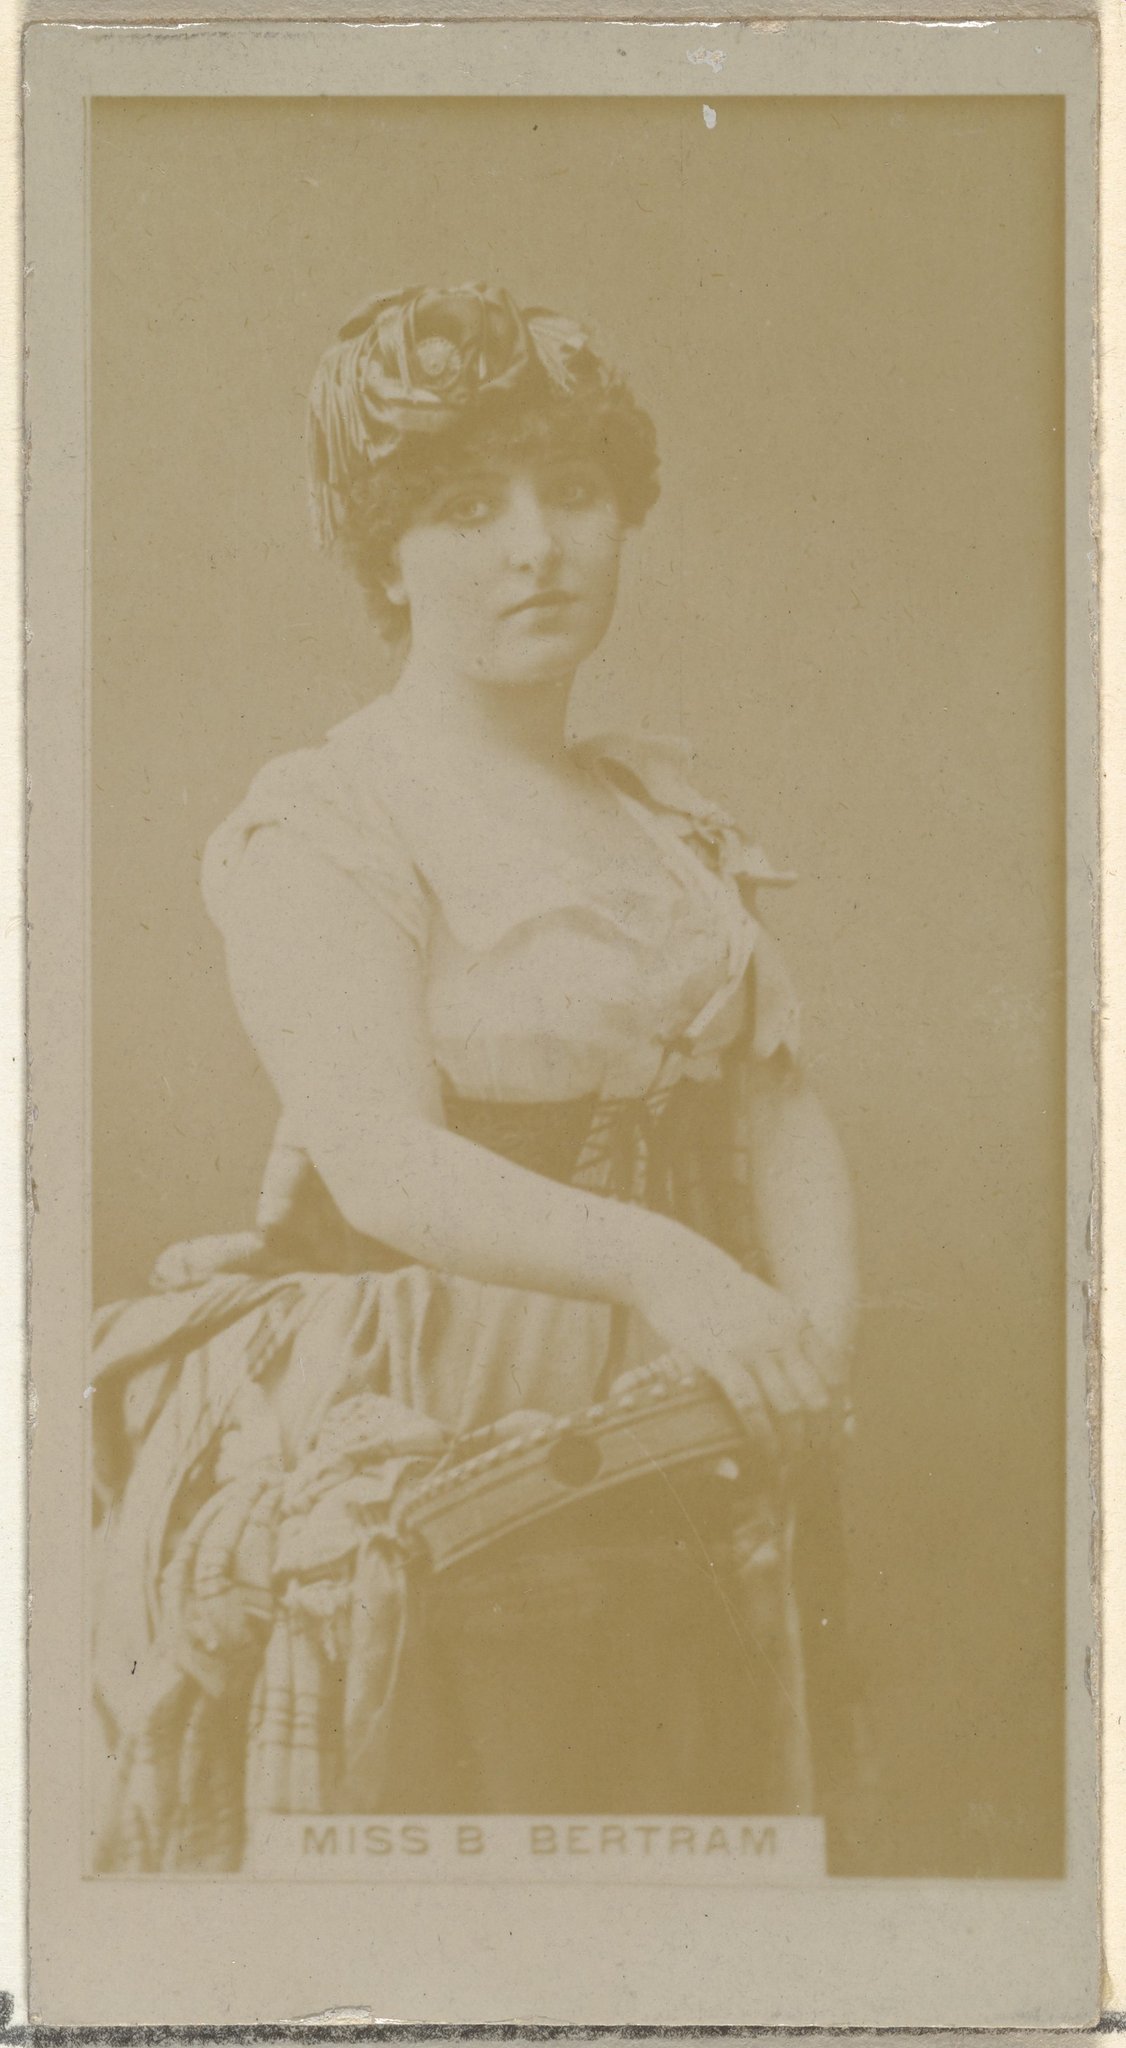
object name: photograph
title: Miss B. Bertram, from the Actors and Actresses series (N145-8) issued by Duke Sons & Co. to promote Duke Cigarettes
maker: w. duke, sons & co.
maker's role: publisher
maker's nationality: american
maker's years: 1870-1920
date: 1891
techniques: albumen silver print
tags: portraits,women,actresses